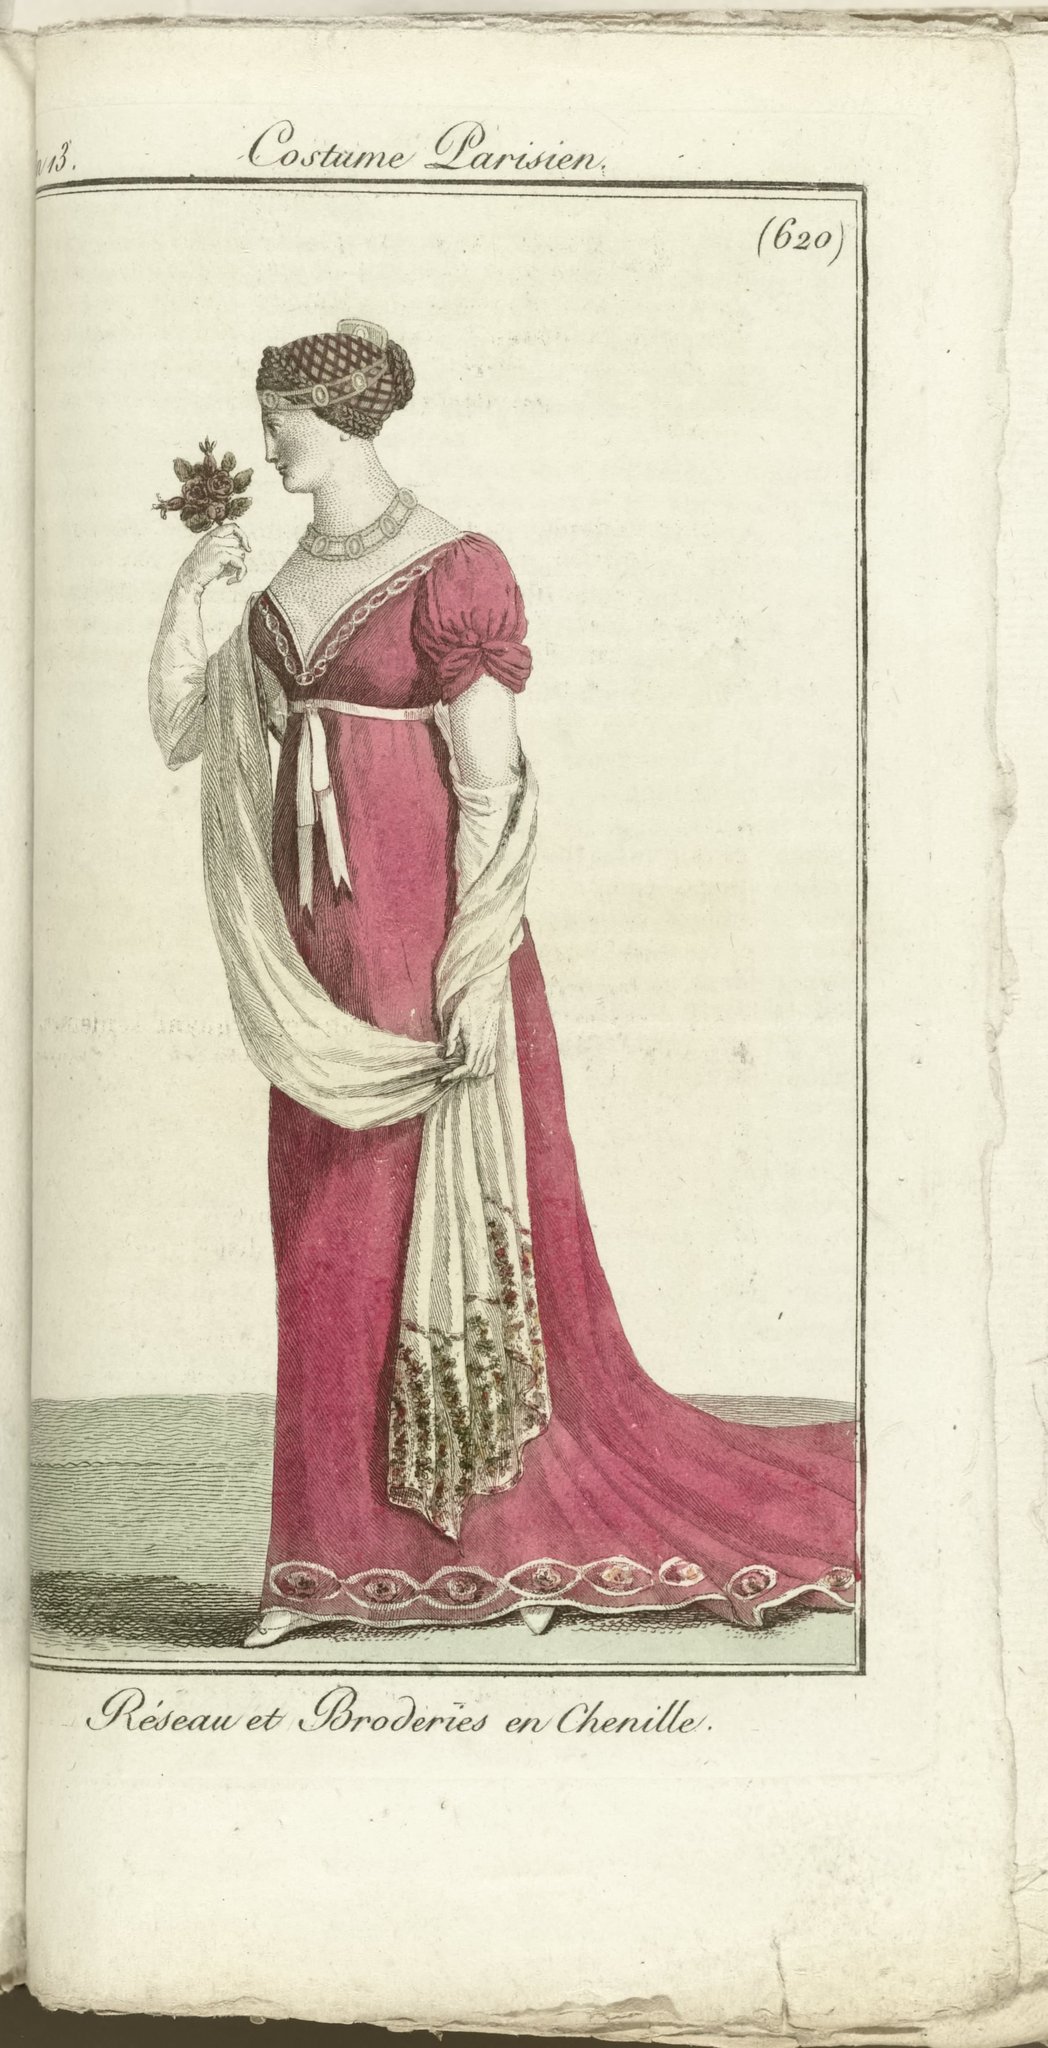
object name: fashion print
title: Journal des Dames et des Modes, Costume Parisien, 1805, An 13 (620) Réseau et Broderies en Chenille.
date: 1805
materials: paper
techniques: engraving, hand coloring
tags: diadem, tiara (+ women's clothes), gloves, mittens (long gloves) (+ women's clothes), neck-gear ~ clothing (shawl) (+ women's clothes), fashion plates, dress, gown (+ women's clothes), pearl; pearl necklace (+ women's clothes)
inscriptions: title: ‘Réseau et Broderies en Chenille.’